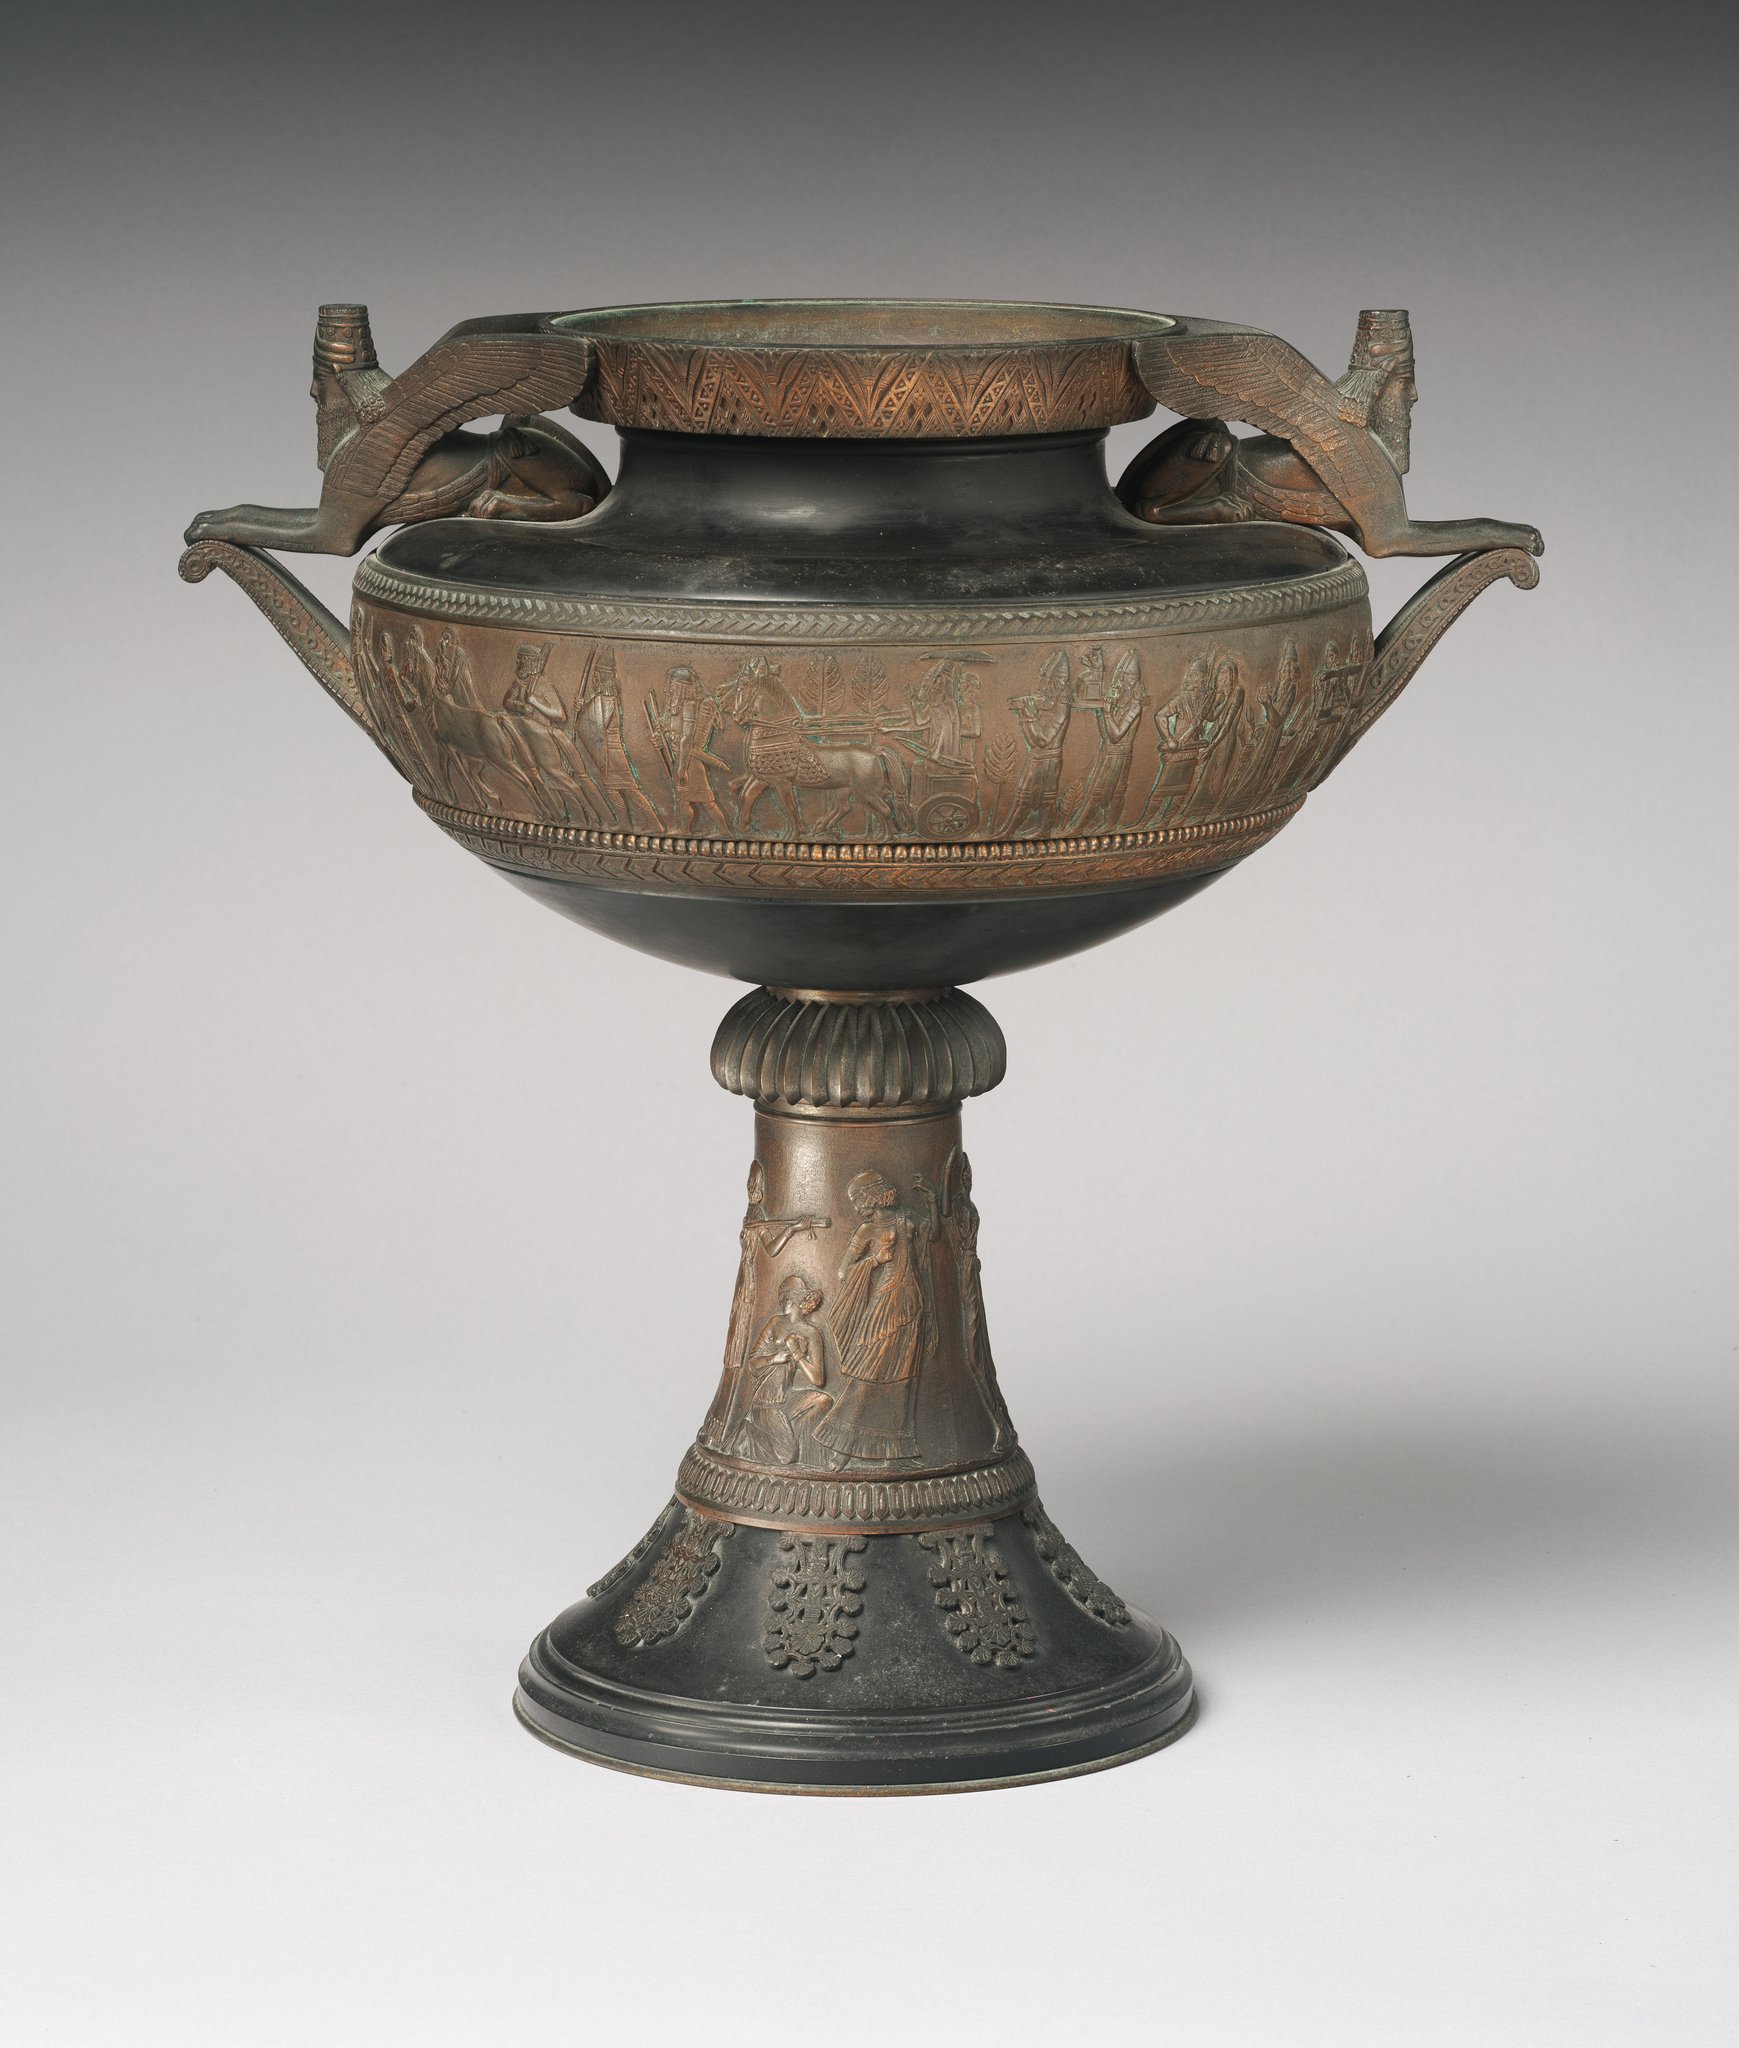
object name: urn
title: Urn with Assyrian scenes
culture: french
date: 1851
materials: bronze